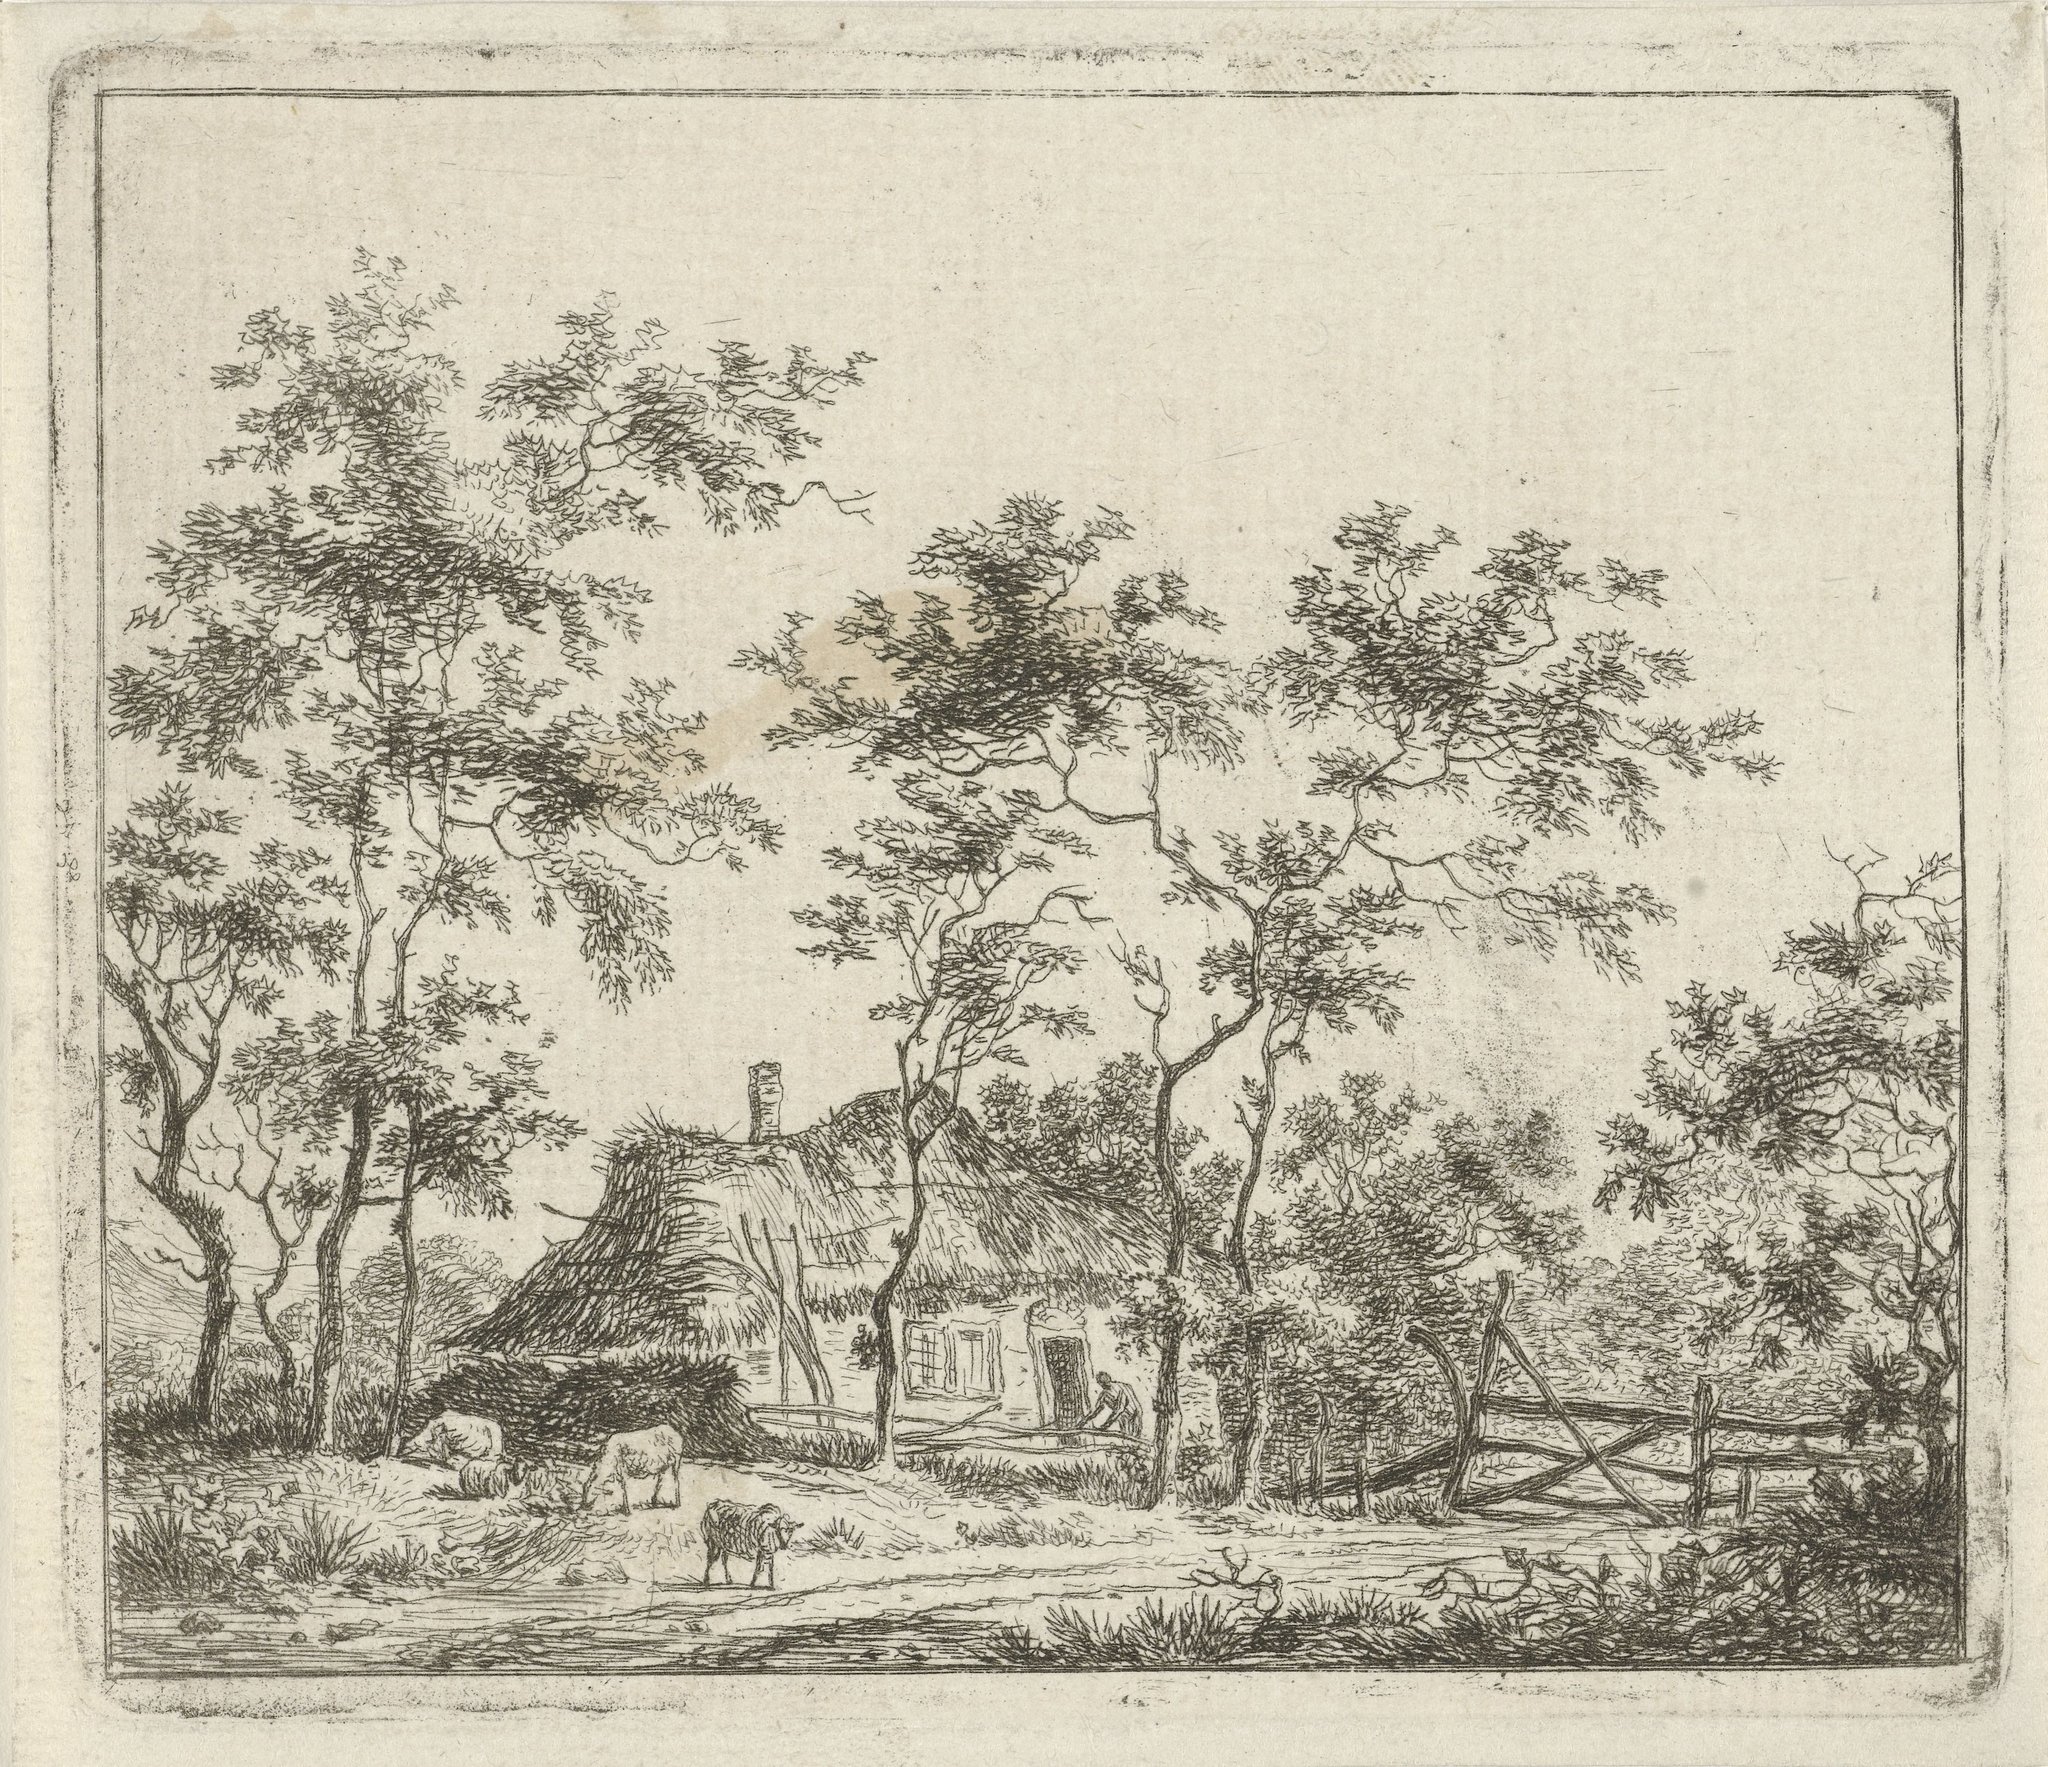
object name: print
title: Boerderij met vier schapen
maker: hermanus fock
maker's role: conservator, draughtsman, painter, print maker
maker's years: 1766-1822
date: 1781-1822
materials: paper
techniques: etching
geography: amsterdam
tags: farm or solitary house in landscape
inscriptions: collector's mark: Lugt 2228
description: Een gezicht op een boerderij met rieten dak en een houten hek waarachter struikgewas. Bij de deur van de boerderij staat een man. Achter de weide met drie staande en een liggend schaap, een bergachtig landschap.